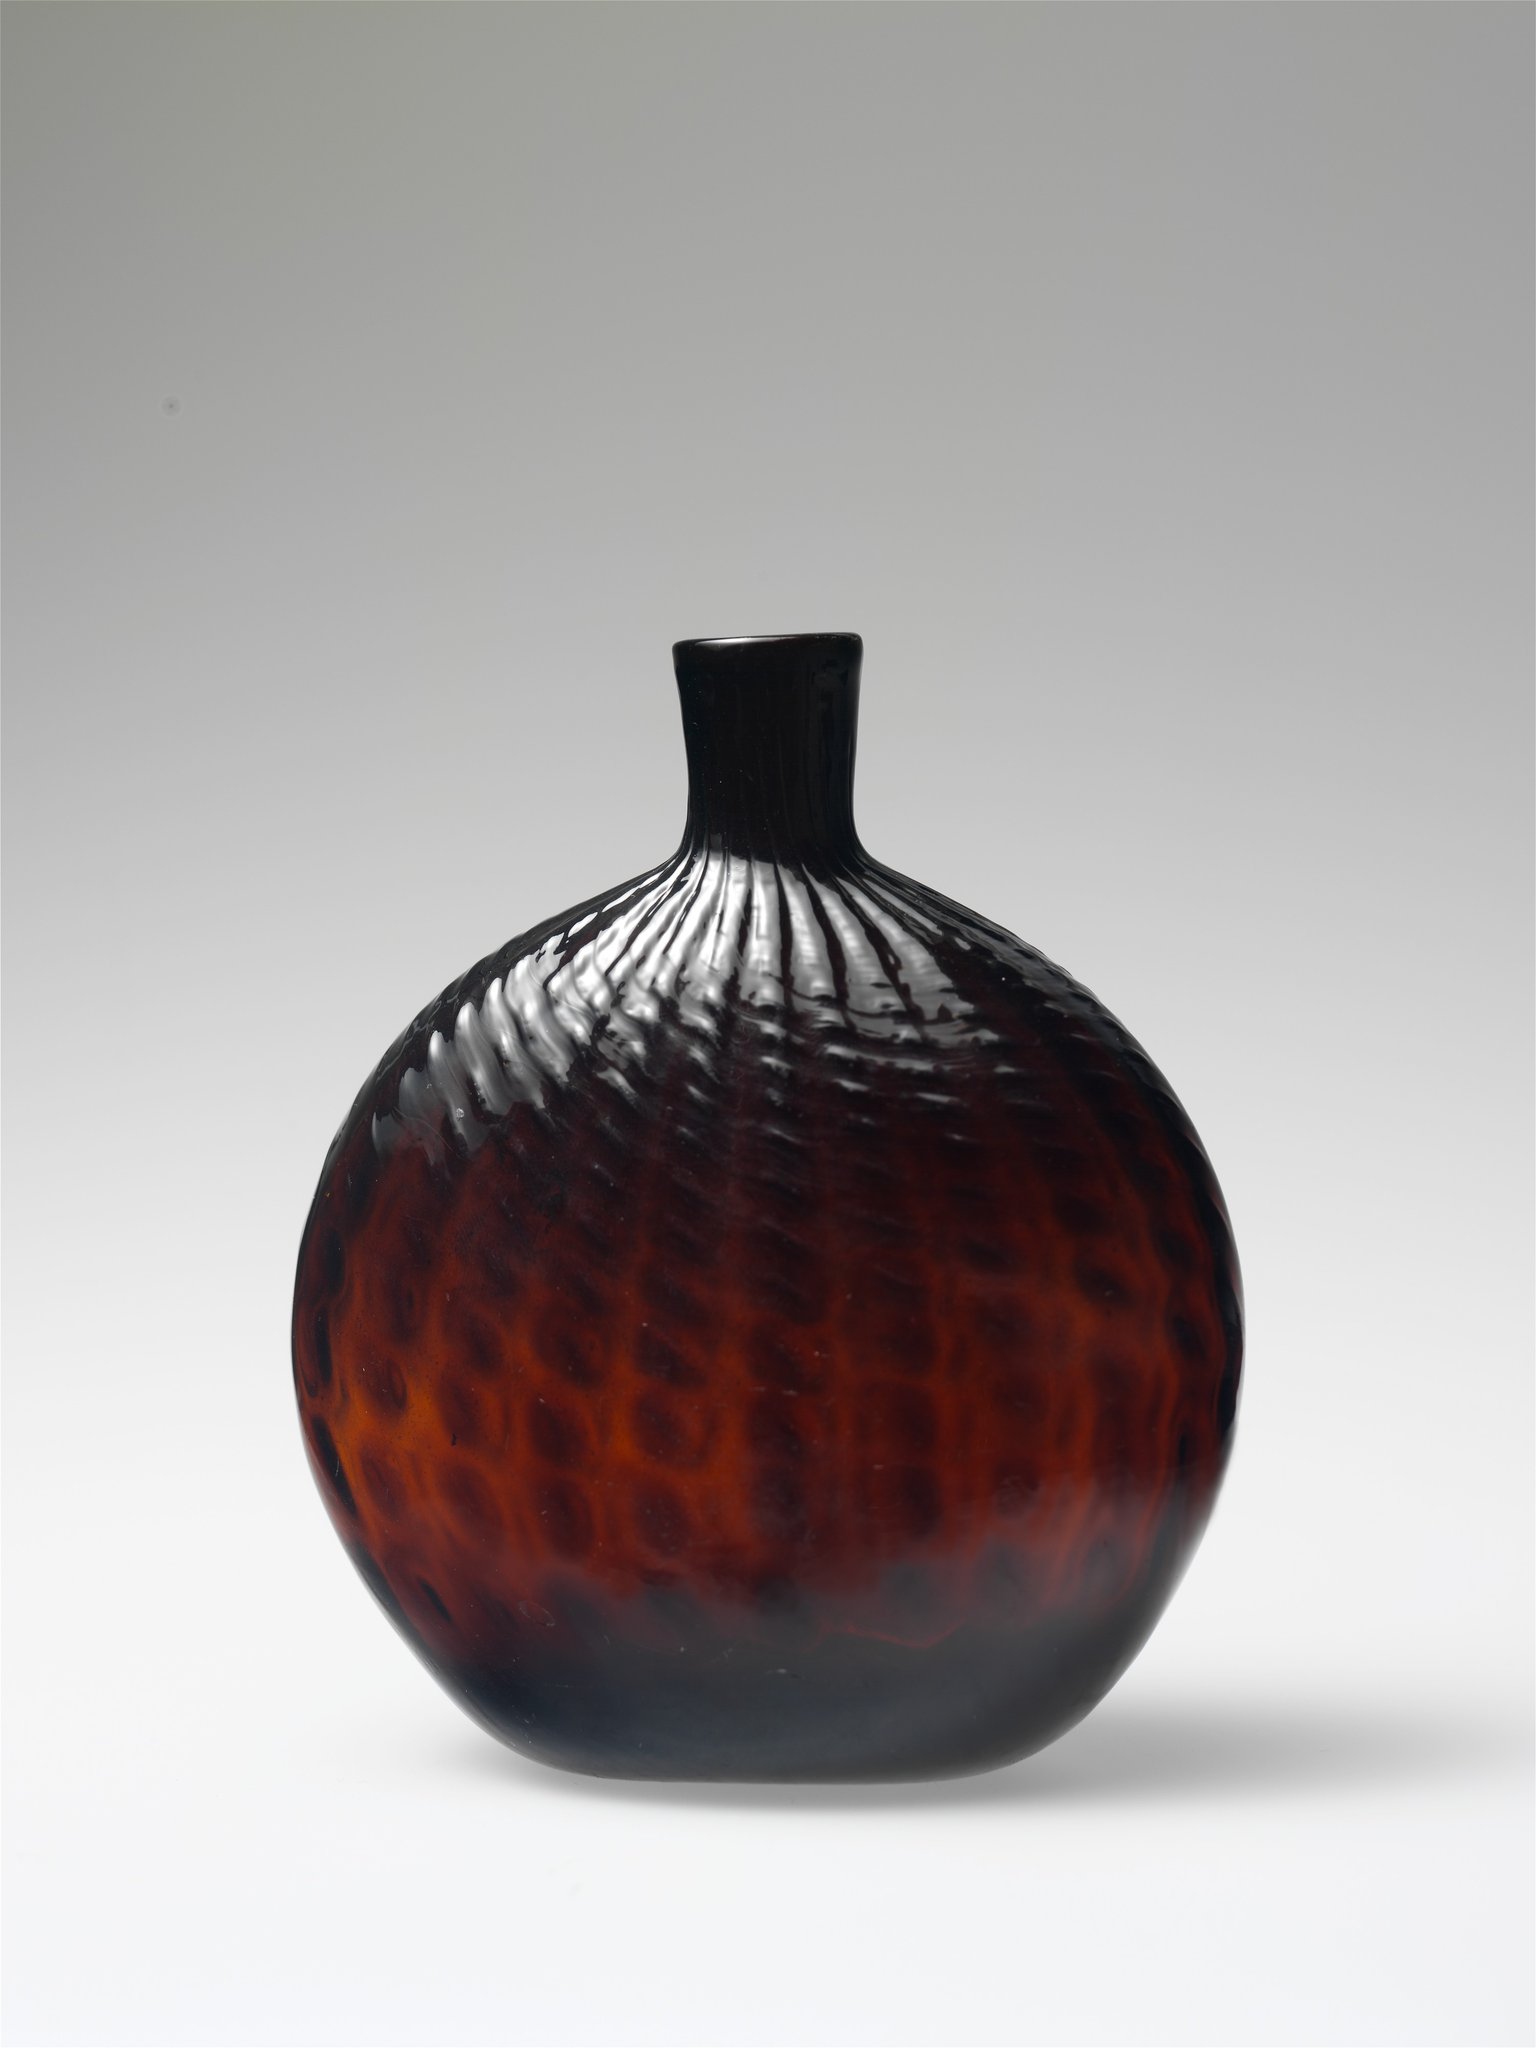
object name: pocket bottle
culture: american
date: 1815-1845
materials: glass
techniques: glassblowing, molding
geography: united states